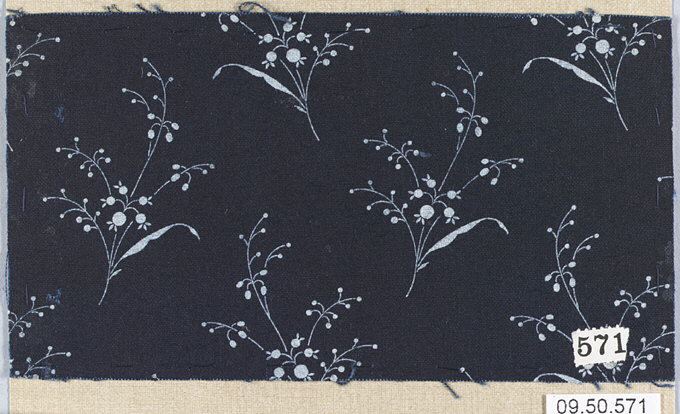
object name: piece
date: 1801-1900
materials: cotton